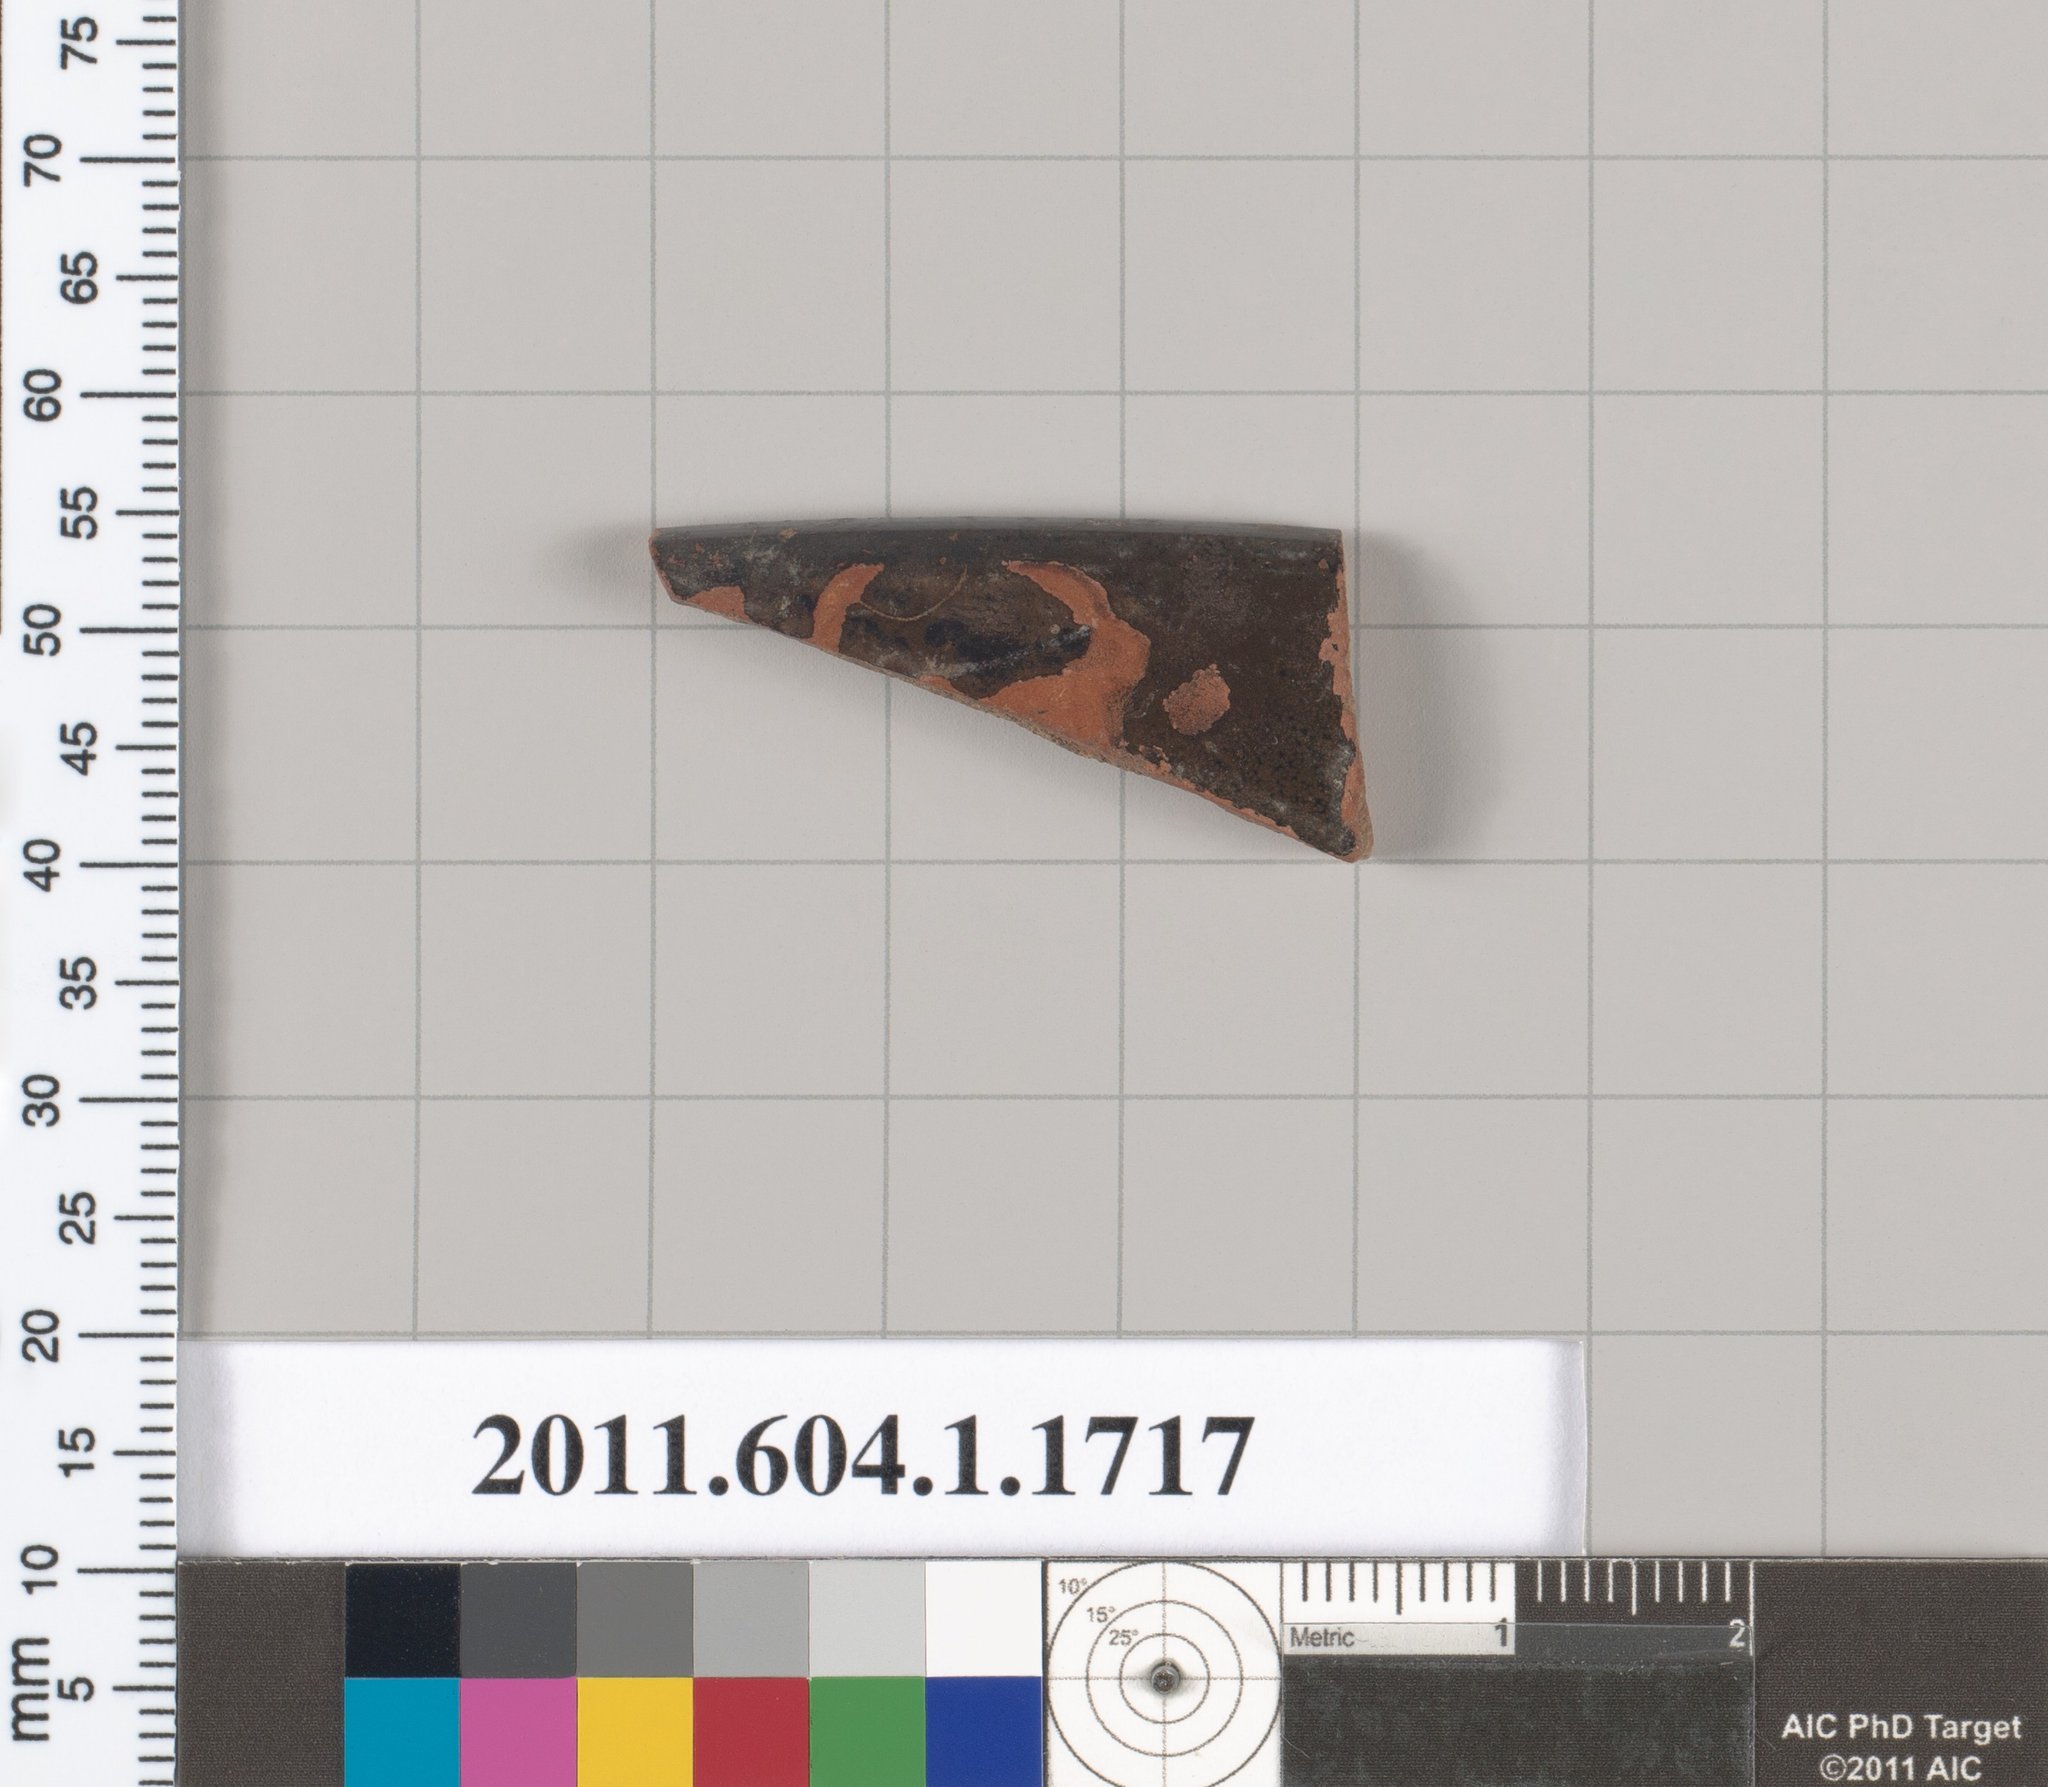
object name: kylix fragment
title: Terracotta rim fragment of a kylix (drinking cup)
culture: greek, attic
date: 467-435 BCE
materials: terracotta